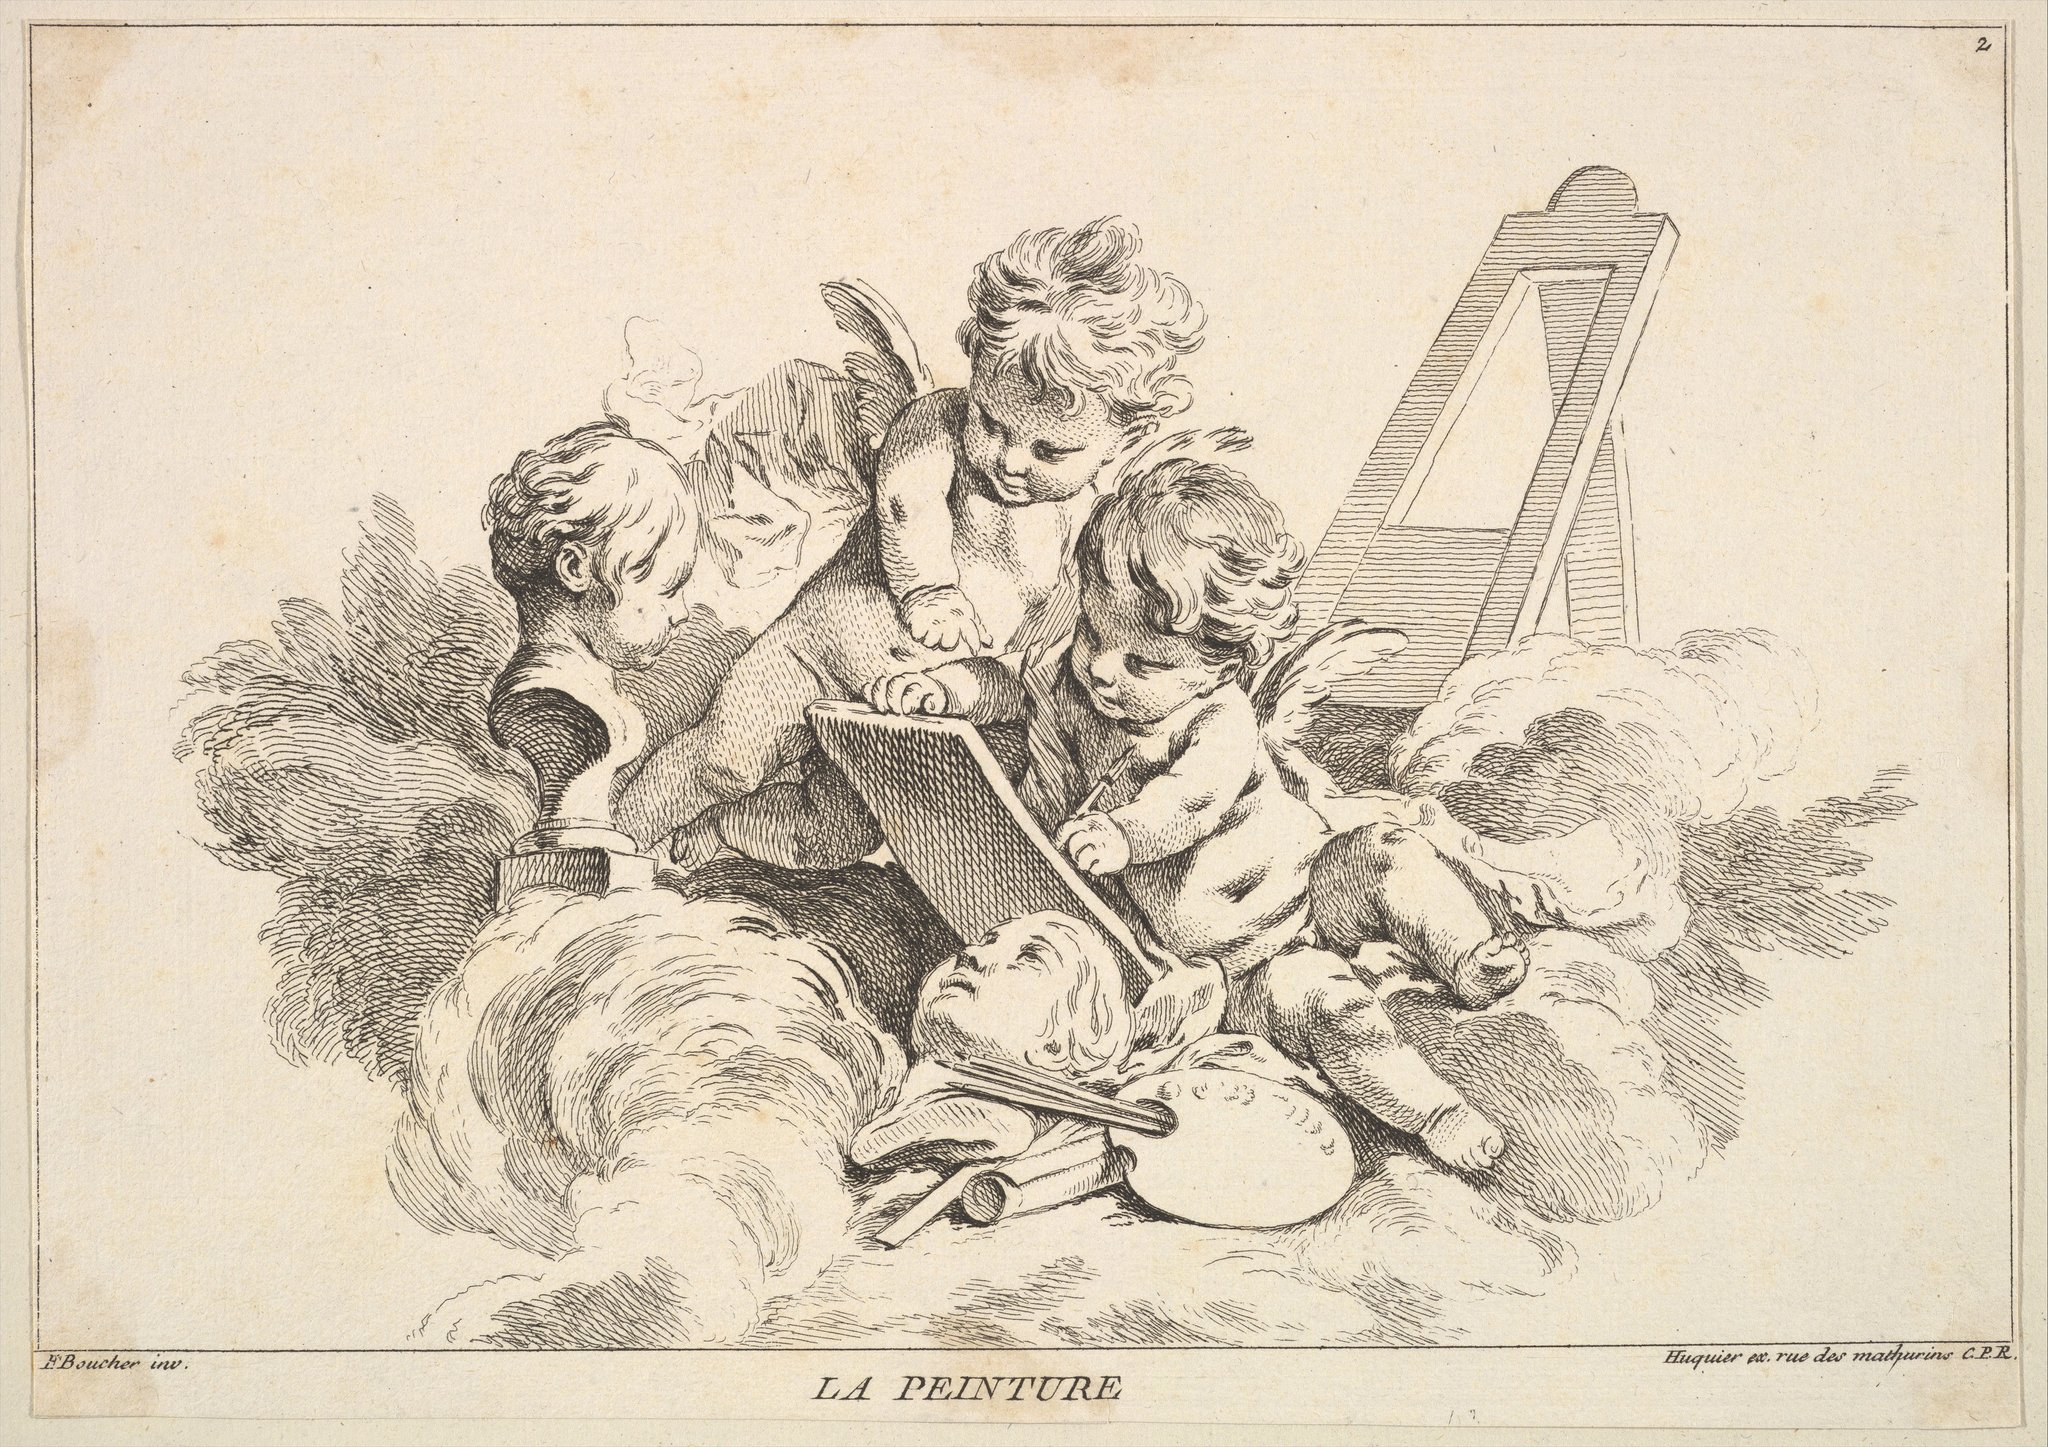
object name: print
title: Painting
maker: louis félix de la rue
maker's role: artist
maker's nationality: french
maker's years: 1731-1765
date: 1731-1765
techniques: etching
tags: painting,sculpture,heads